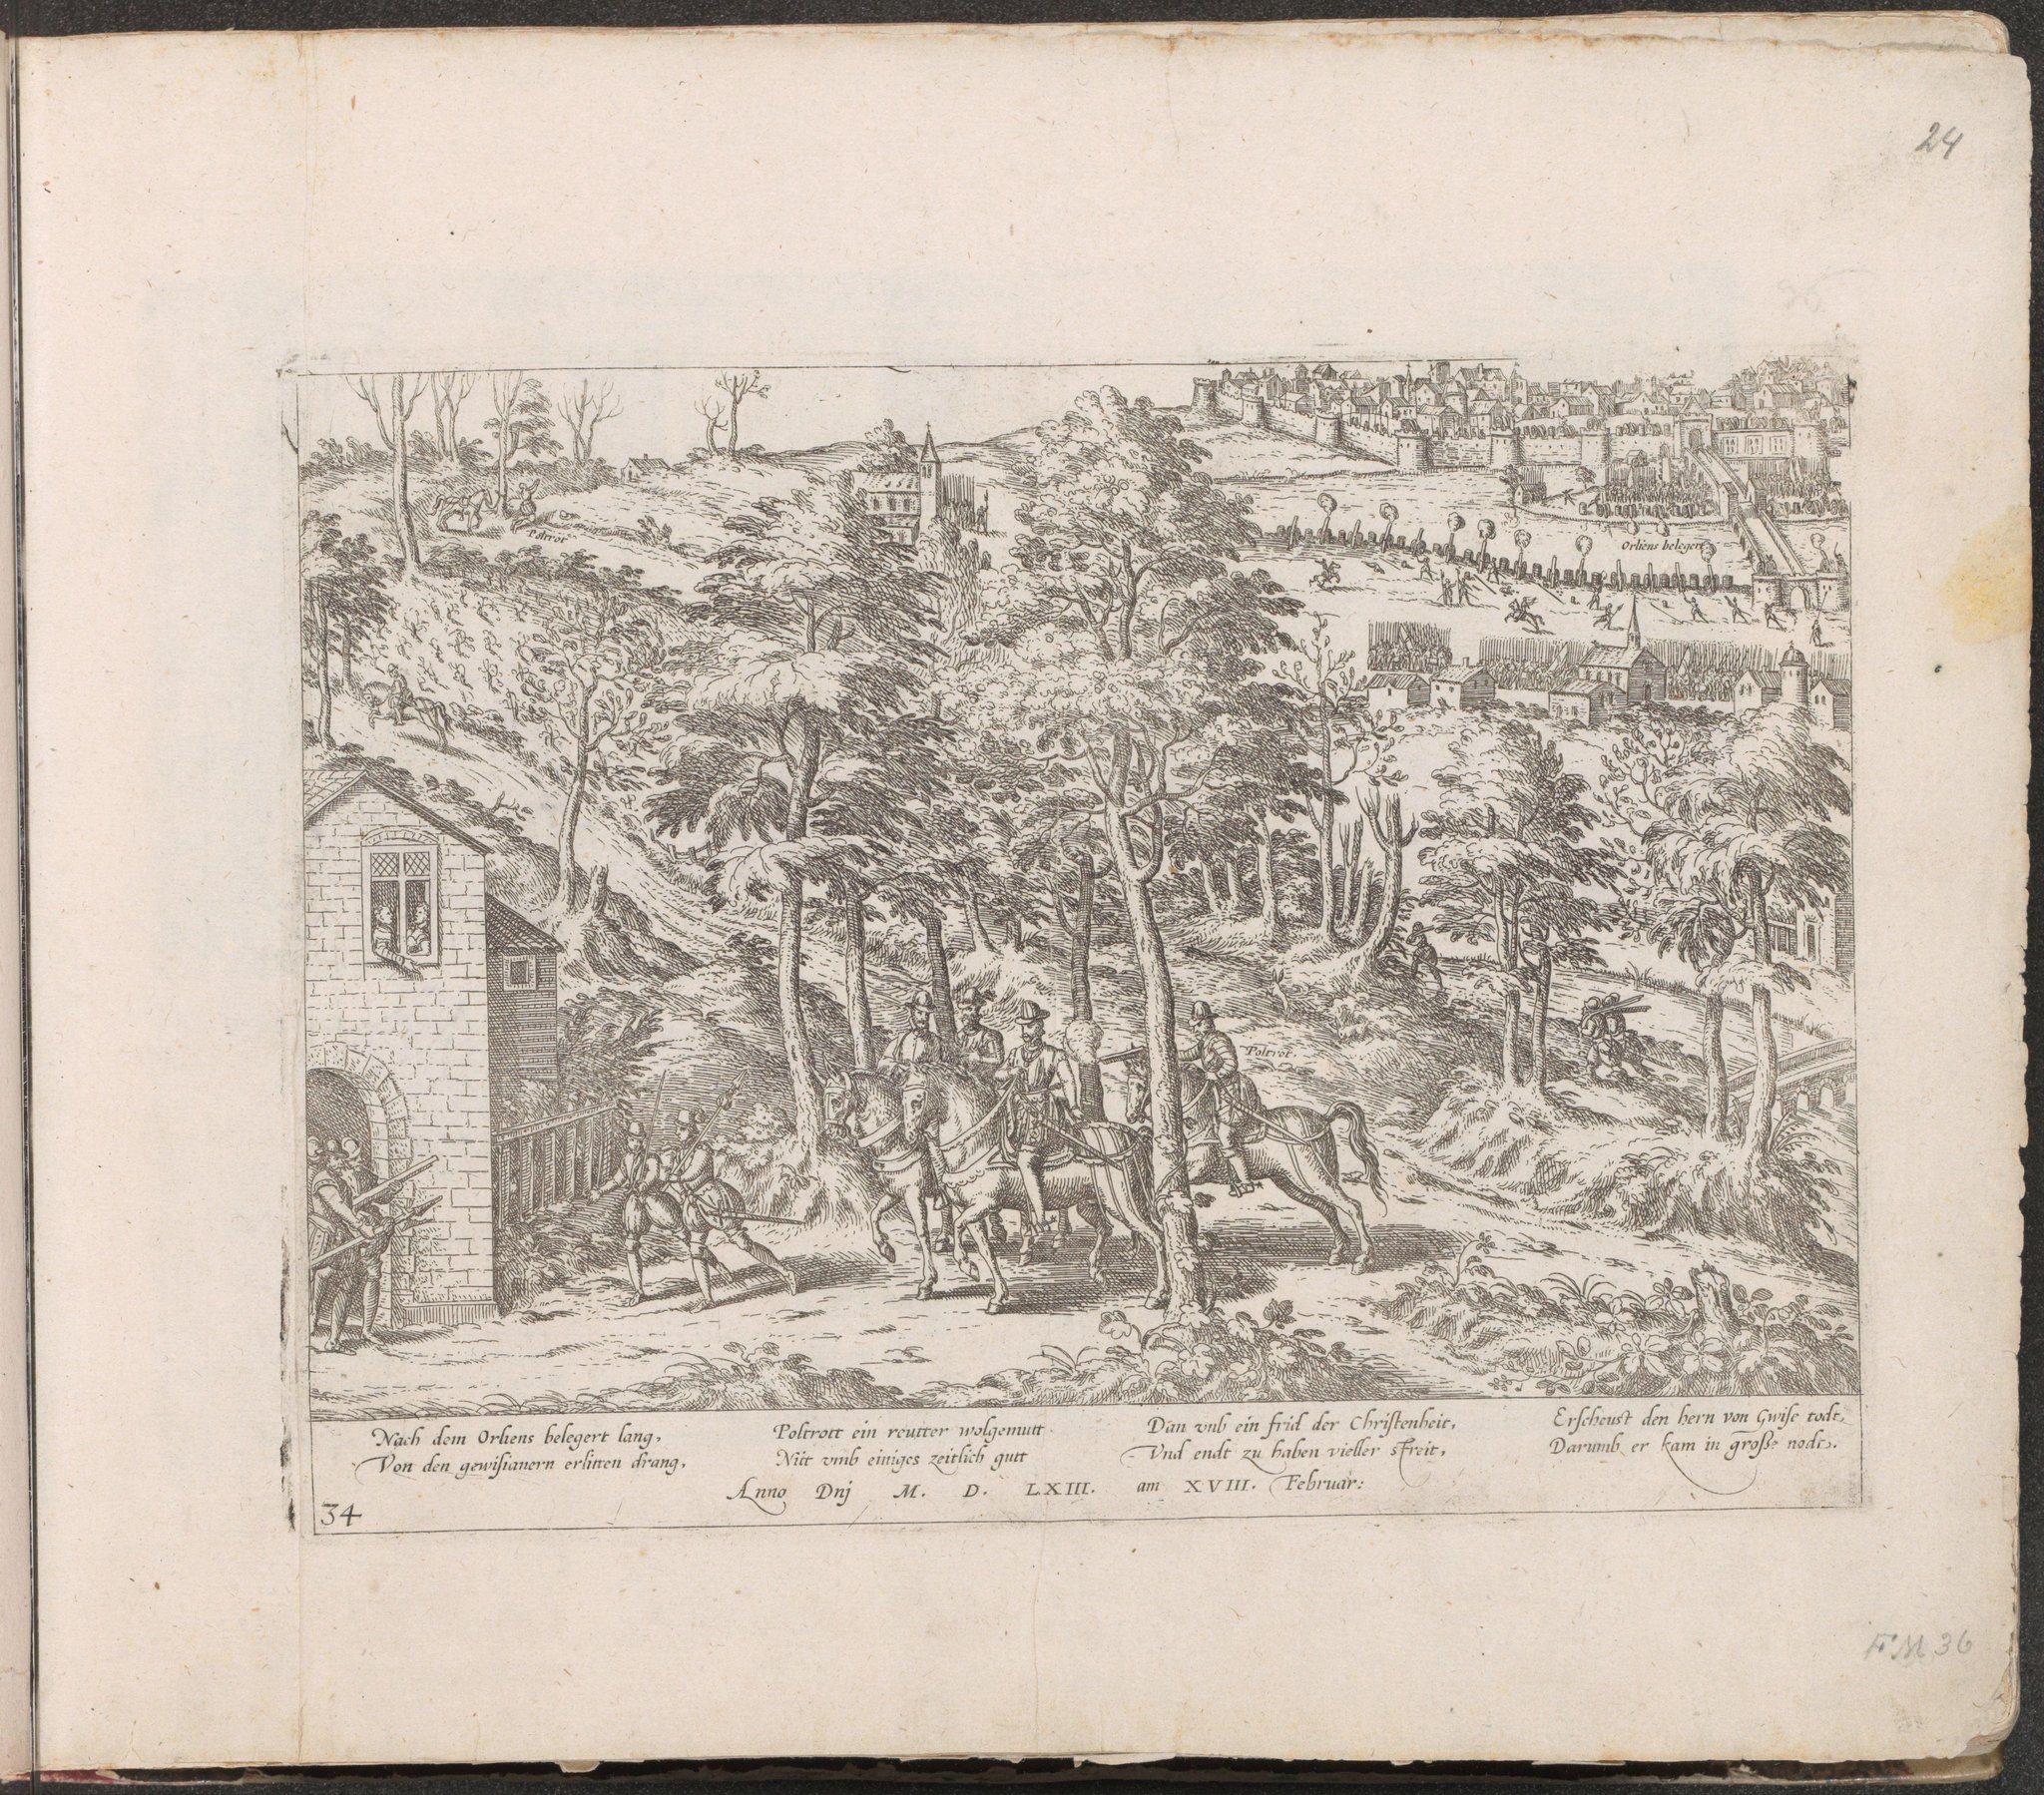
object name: history print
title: Serie 3: Franse Godsdienstoorlogen, 1559-1573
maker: frans hogenberg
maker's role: print maker, publisher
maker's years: 1538-1590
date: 1567-1571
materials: paper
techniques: etching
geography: cologne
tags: siege, position war, violent death, being killed; being mishandled and maltreated; seeking death, attempt, political murder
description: Beleg van Orléans en de moord op de hertog de Guise door Jean Poltrot, 18 februari 1563. Met onderschrift van 8 regels in het Duits. Linksonder genummerd: 34. De prent maakt deel uit van een album.